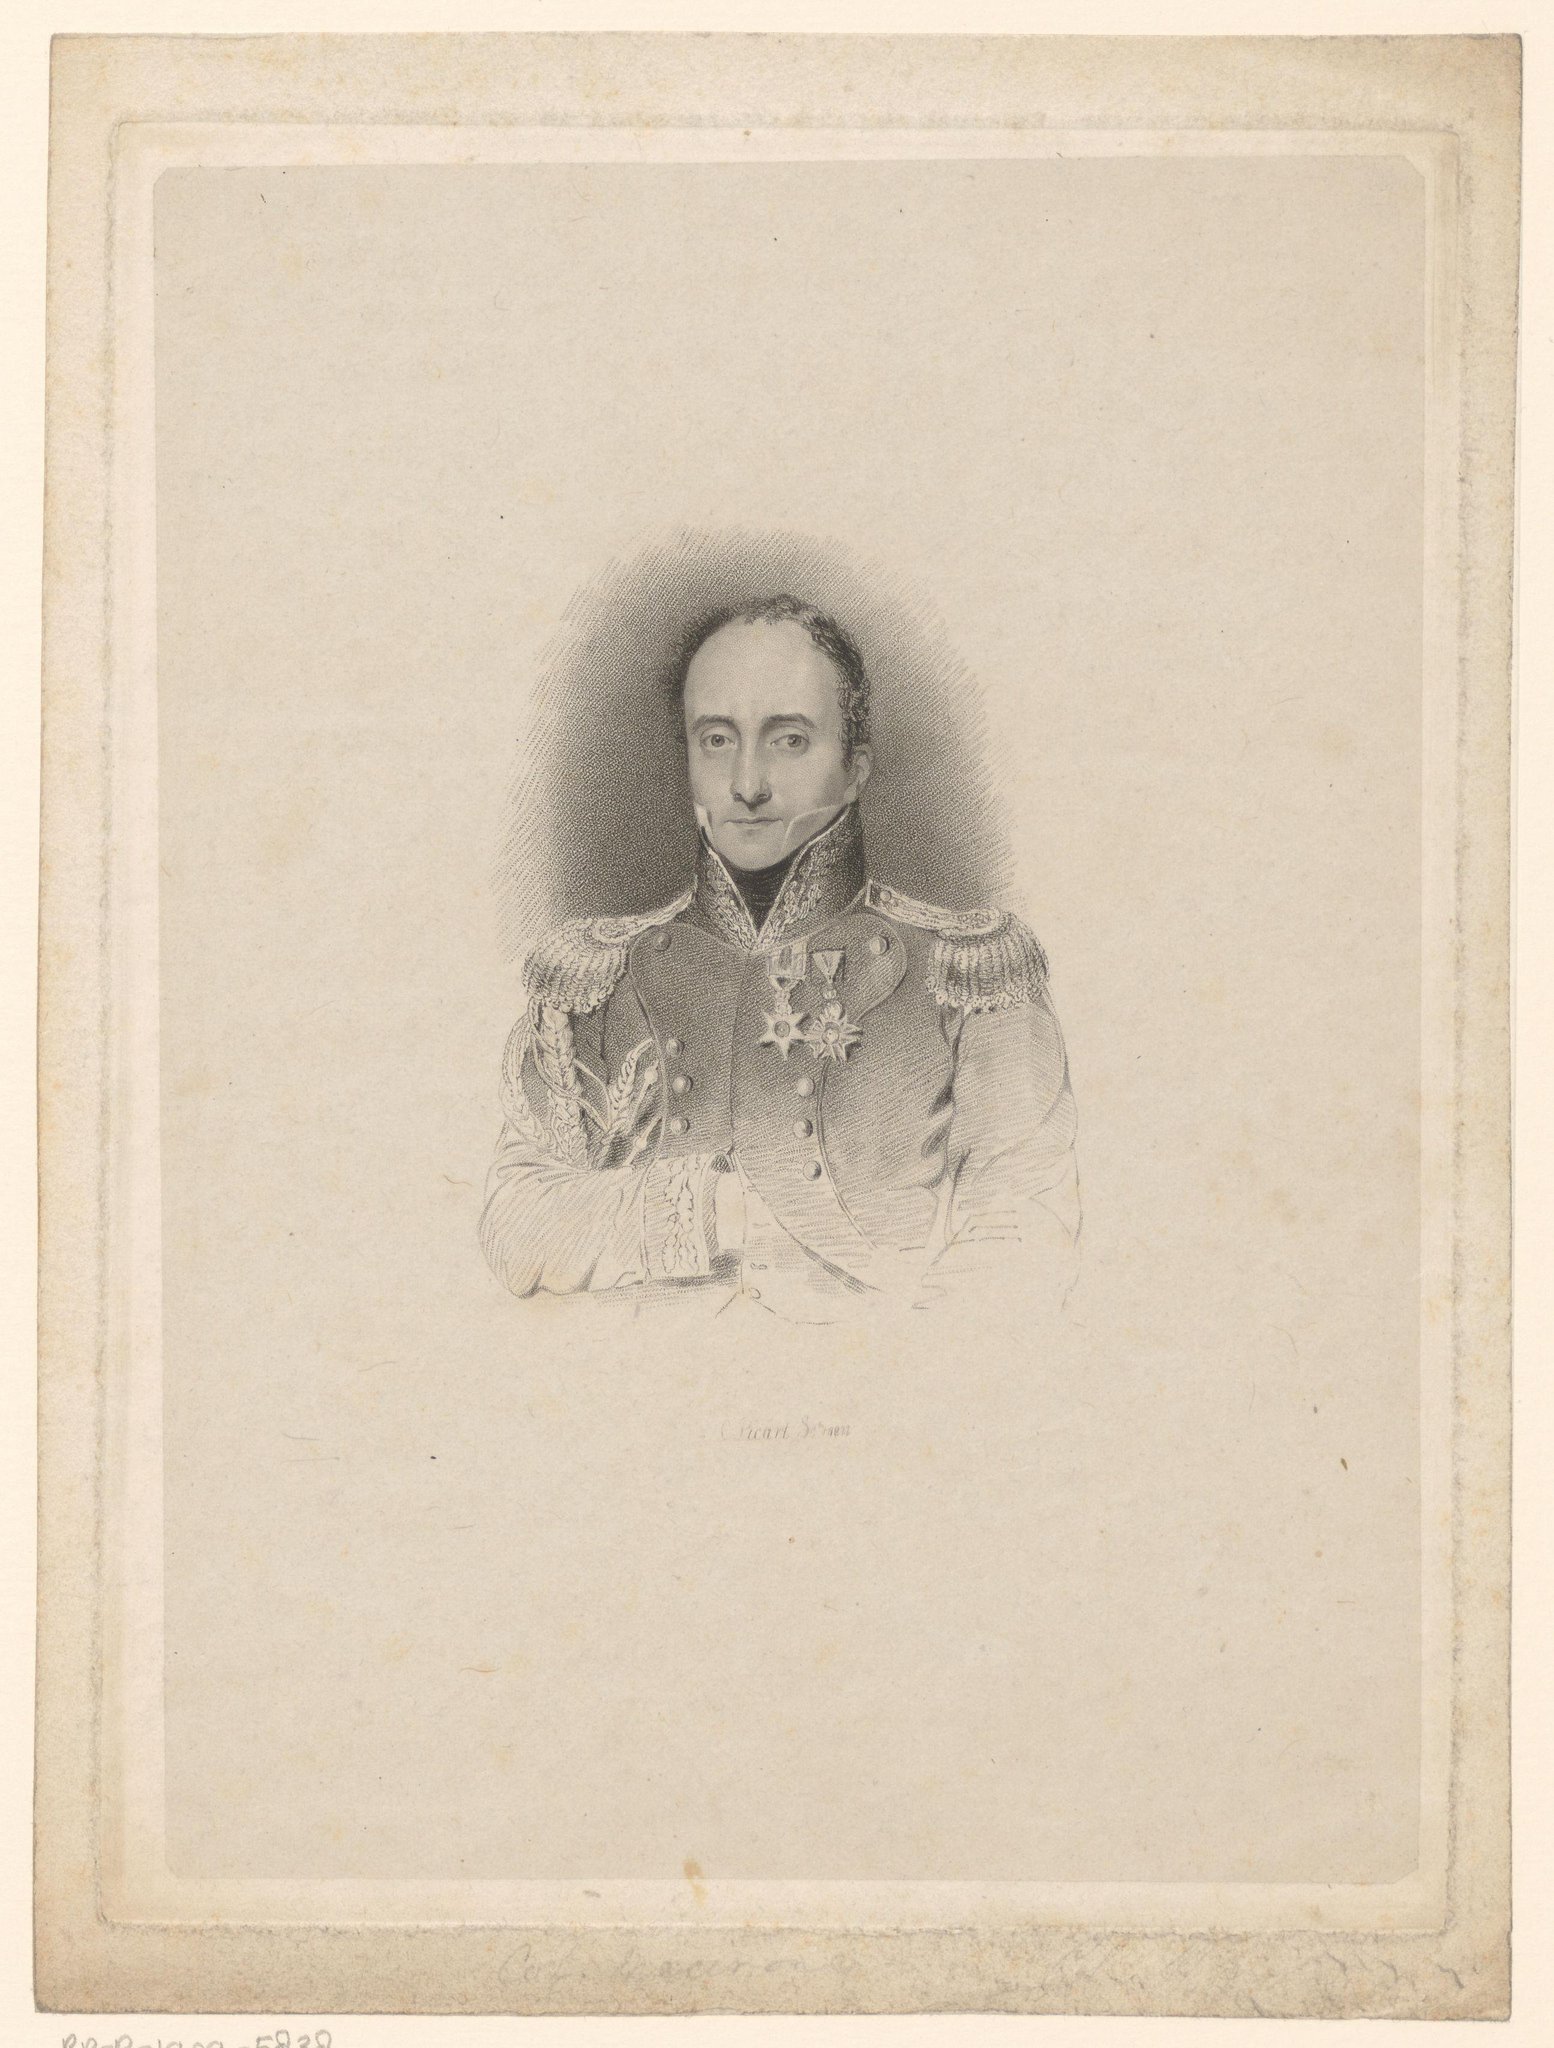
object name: print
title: Portret van Francis Maceroni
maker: charles picart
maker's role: print maker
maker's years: 1780-1837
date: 1822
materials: paper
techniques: etching, roulette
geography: england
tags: manchester, london, engineering (+ portrait of scholar, scientist), historical persons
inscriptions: collector's mark: Lugt 2228